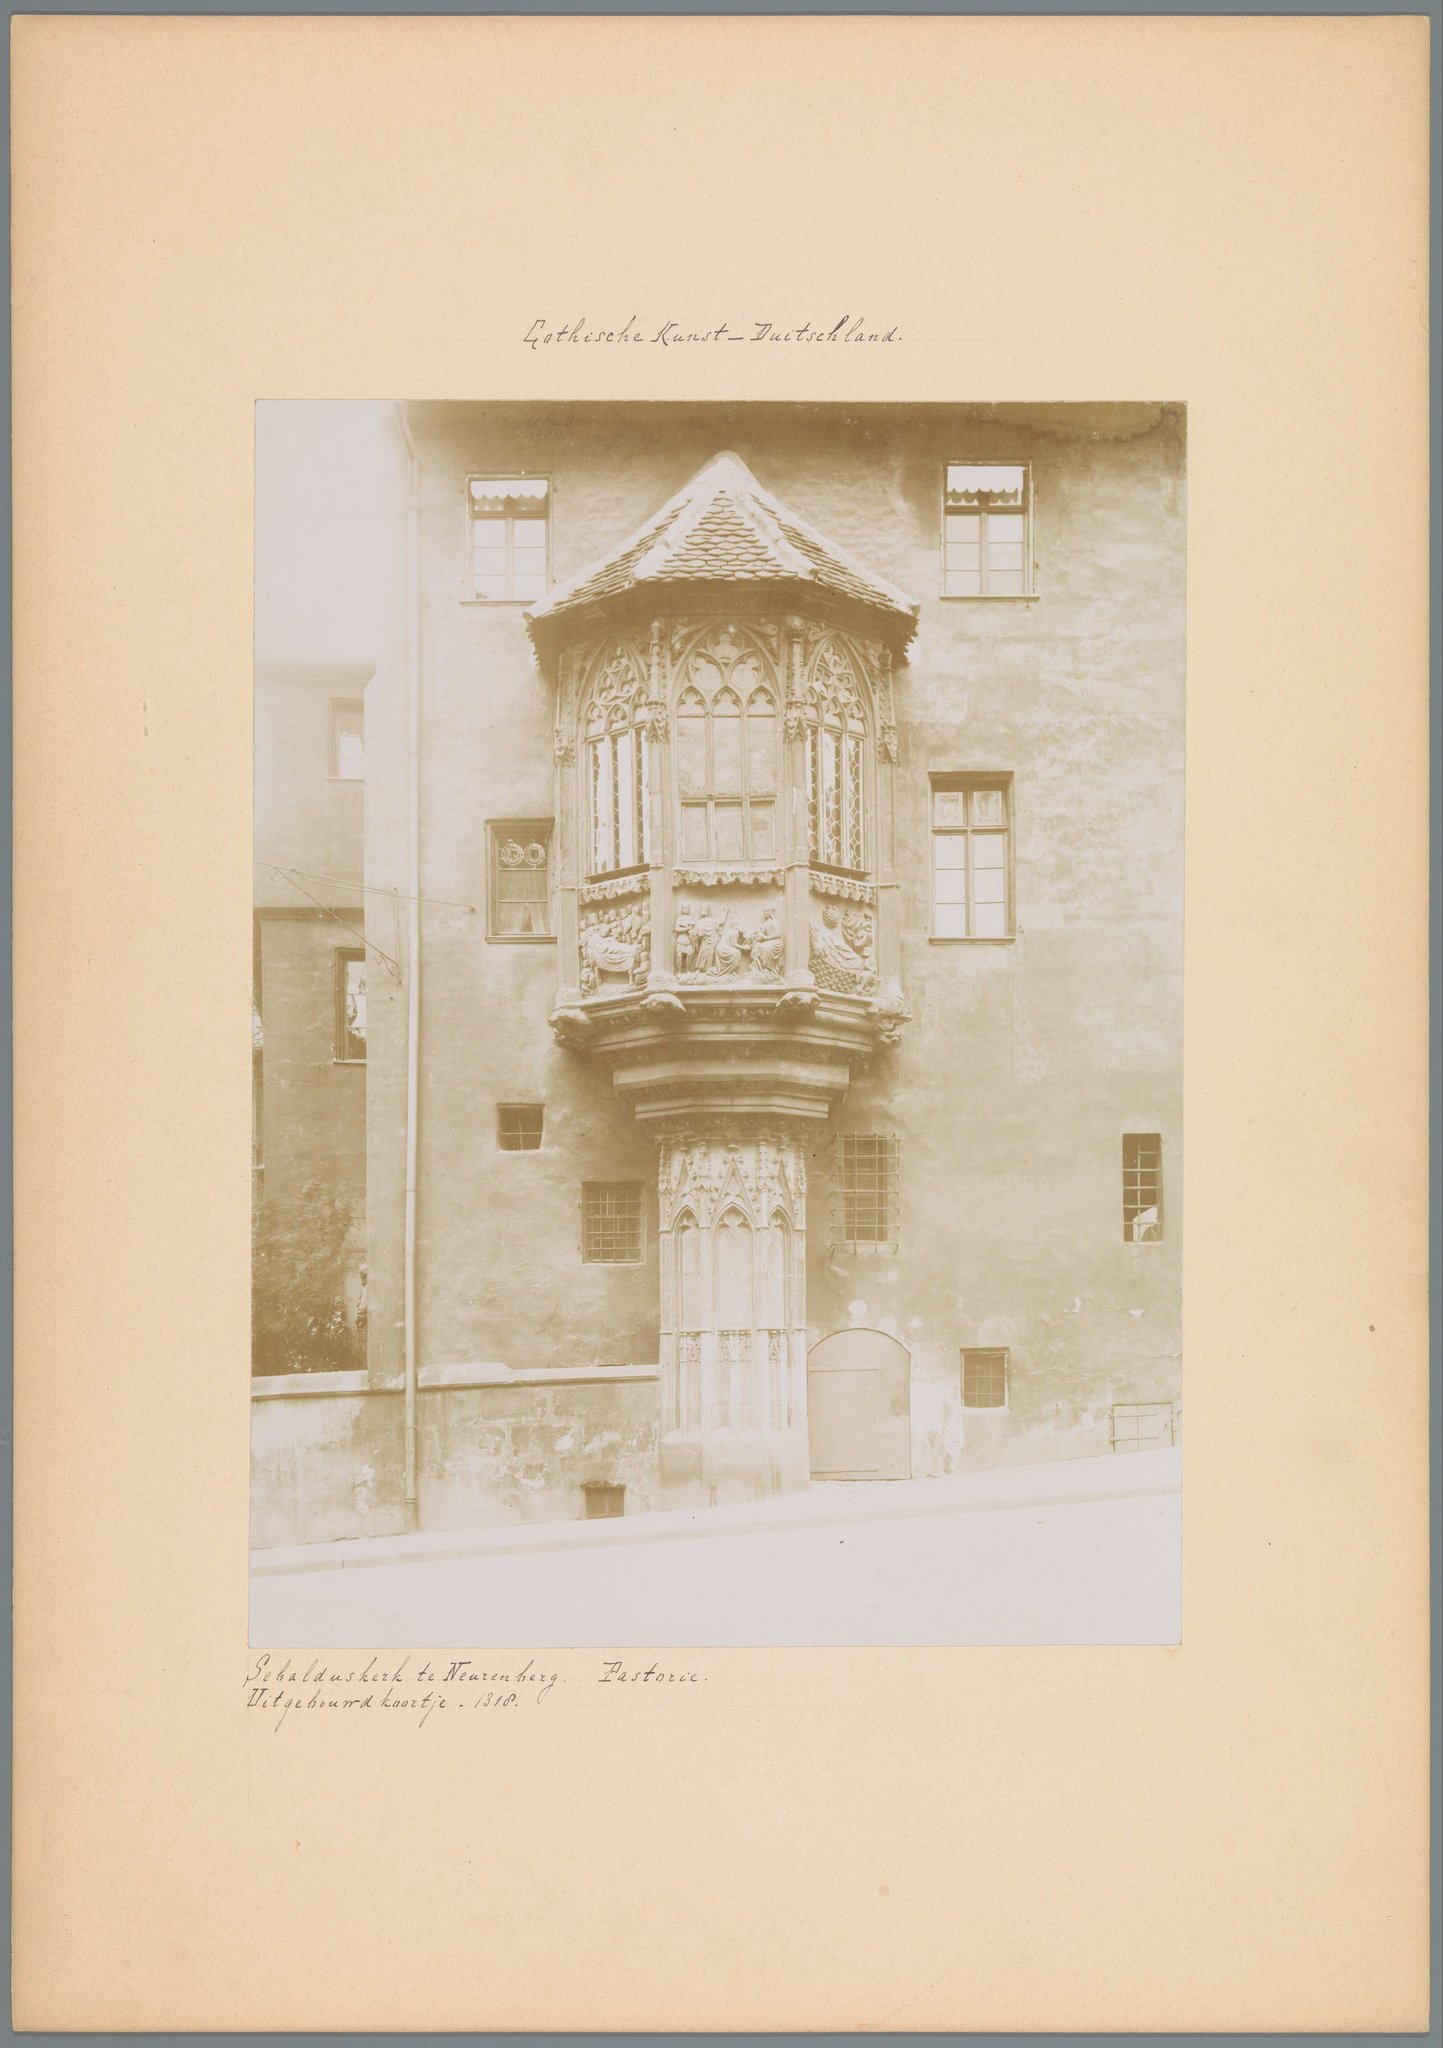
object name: photograph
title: Exterieur van het koor van de pastorie van de Sint-Sebalduskerk te Neurenberg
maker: Anonymous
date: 1875-1900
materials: cardboard, photographic support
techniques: collodion silver print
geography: nuremberg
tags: church (exterior)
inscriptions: collector's mark: ‘KUNSTNIJVERHEIDSCHOOL QUELLINUS AMSTERDAM FRANS HALSSTRAAT 14.’, inscription: ‘Gothische Kunst - Duitschland.’, collector's mark: ‘INSTITUUT VOOR KUNST-NIJVERHEIDSONDERWIJS GABRIËL METSUSTRAAT No. 16 AMSTERDAM’